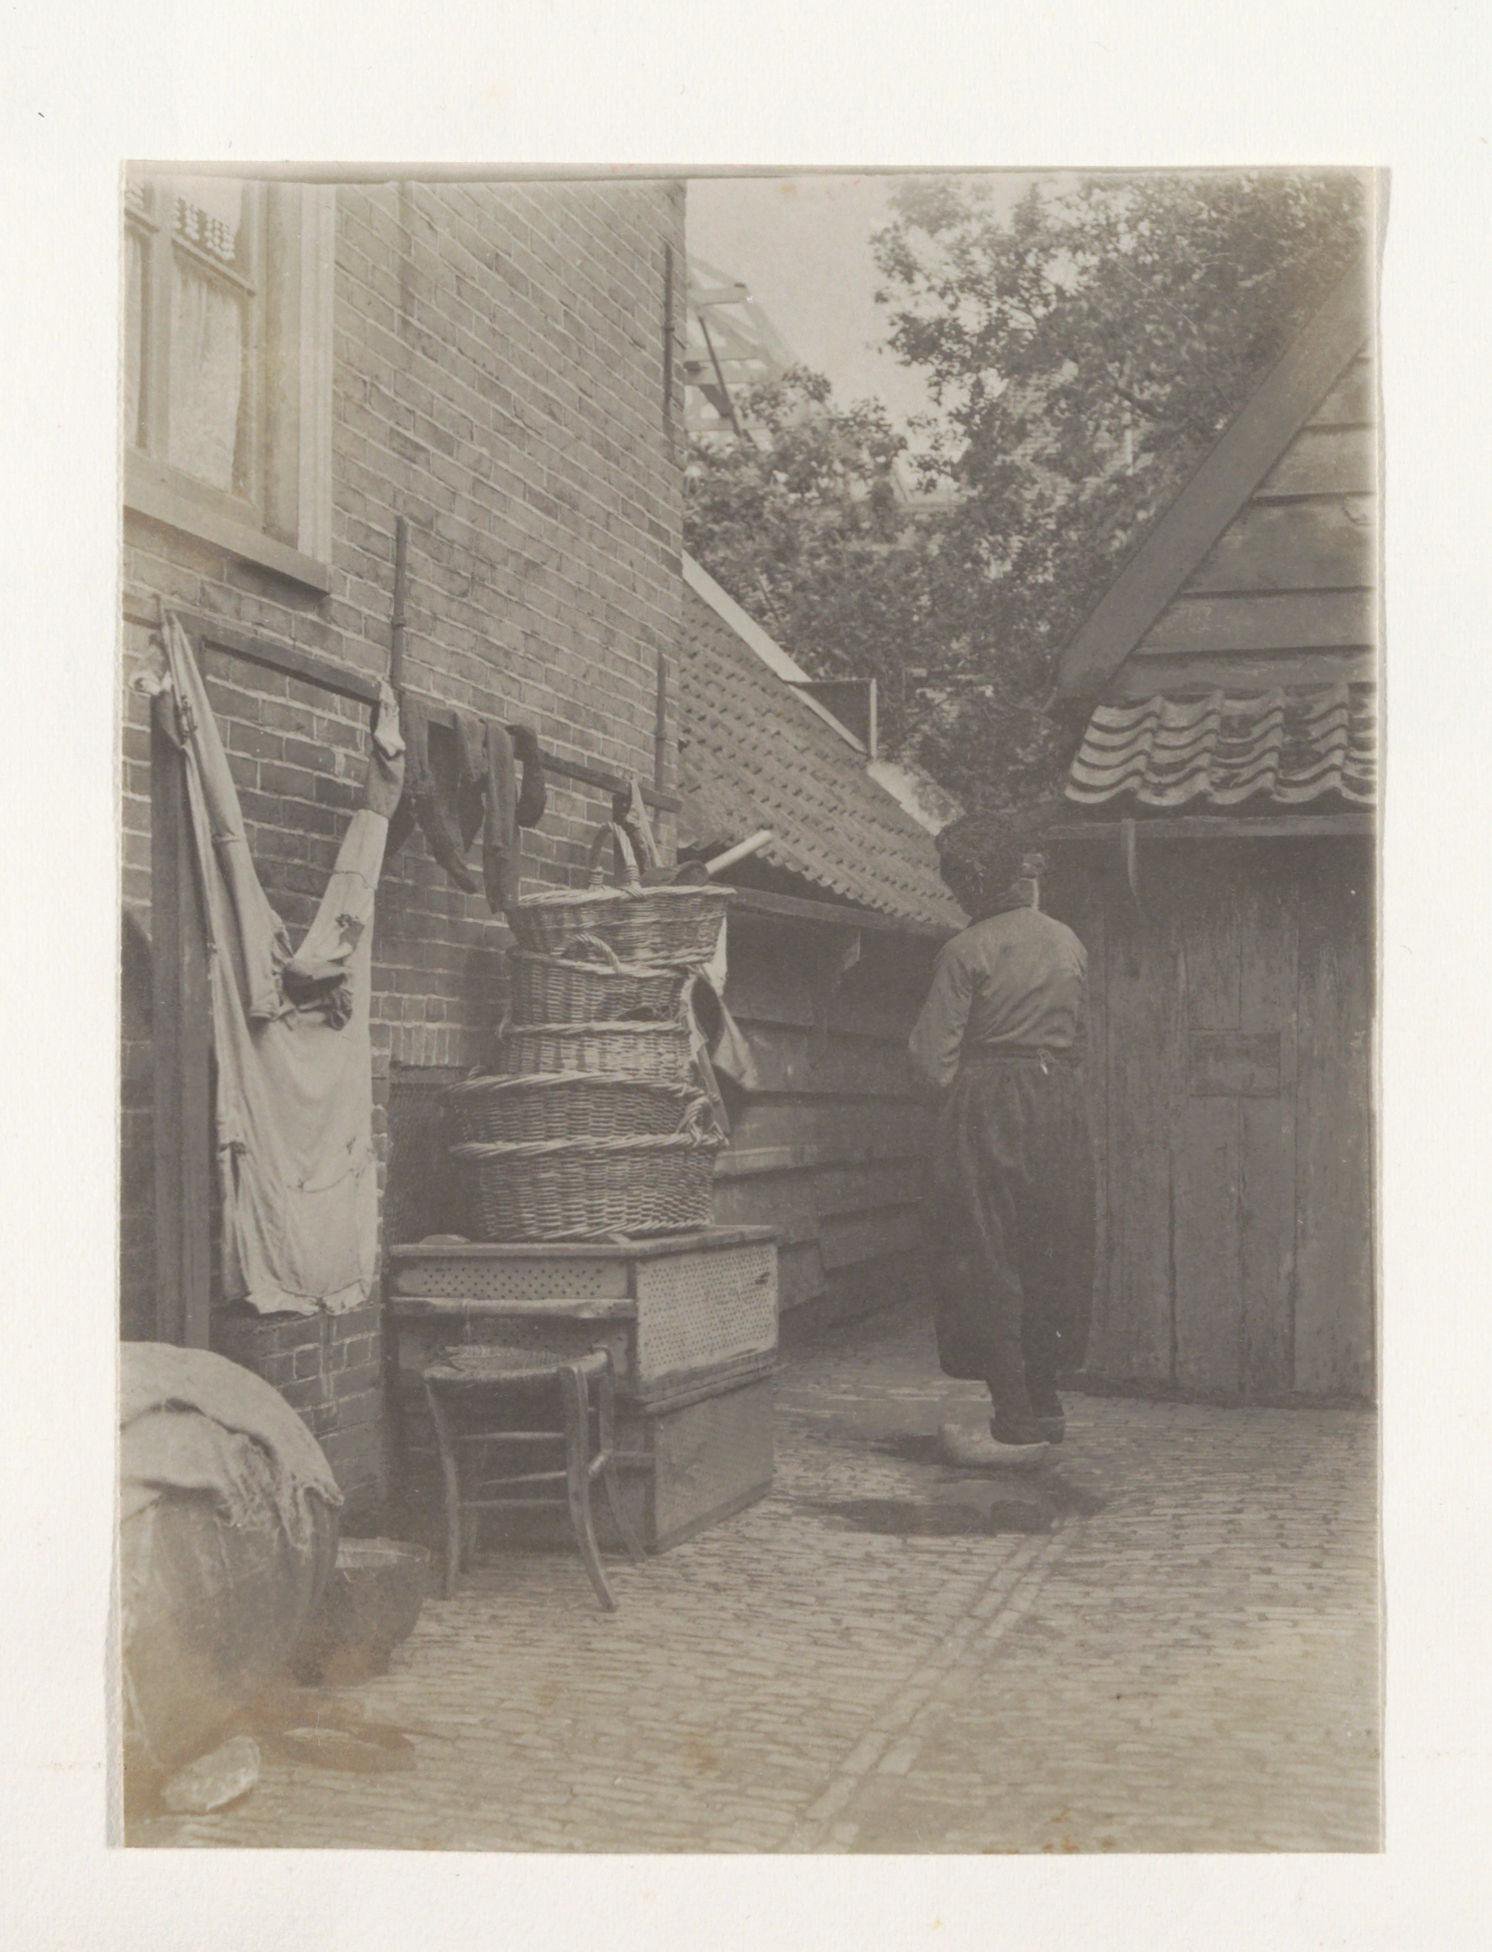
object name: photograph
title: Gezicht op de groenteveiling in Zwijndrecht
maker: george hidderley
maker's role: fotograaf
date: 1903-1910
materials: paper, photographic support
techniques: gelatin silver print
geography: dordrecht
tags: hand-cart, auction sale, public sale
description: Gezicht op de groenteveiling op het Zomerlust te Zwijndrecht. Onderdeel van fotoalbum met opnames van Volendam, Dordrecht, Gorinchem en Woudrichem.